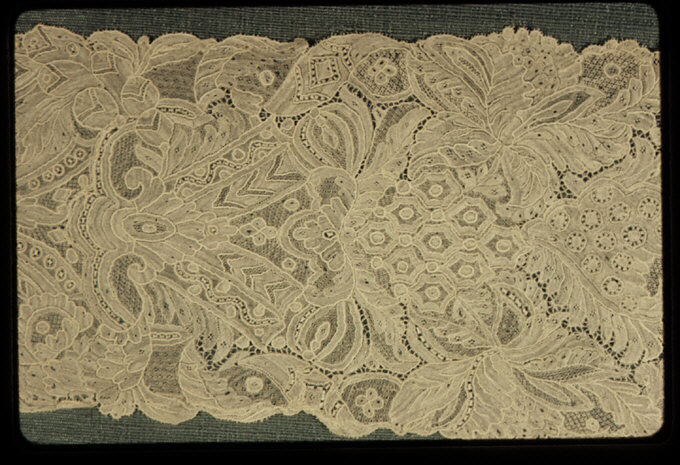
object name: lappet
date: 1701-1800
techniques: lace